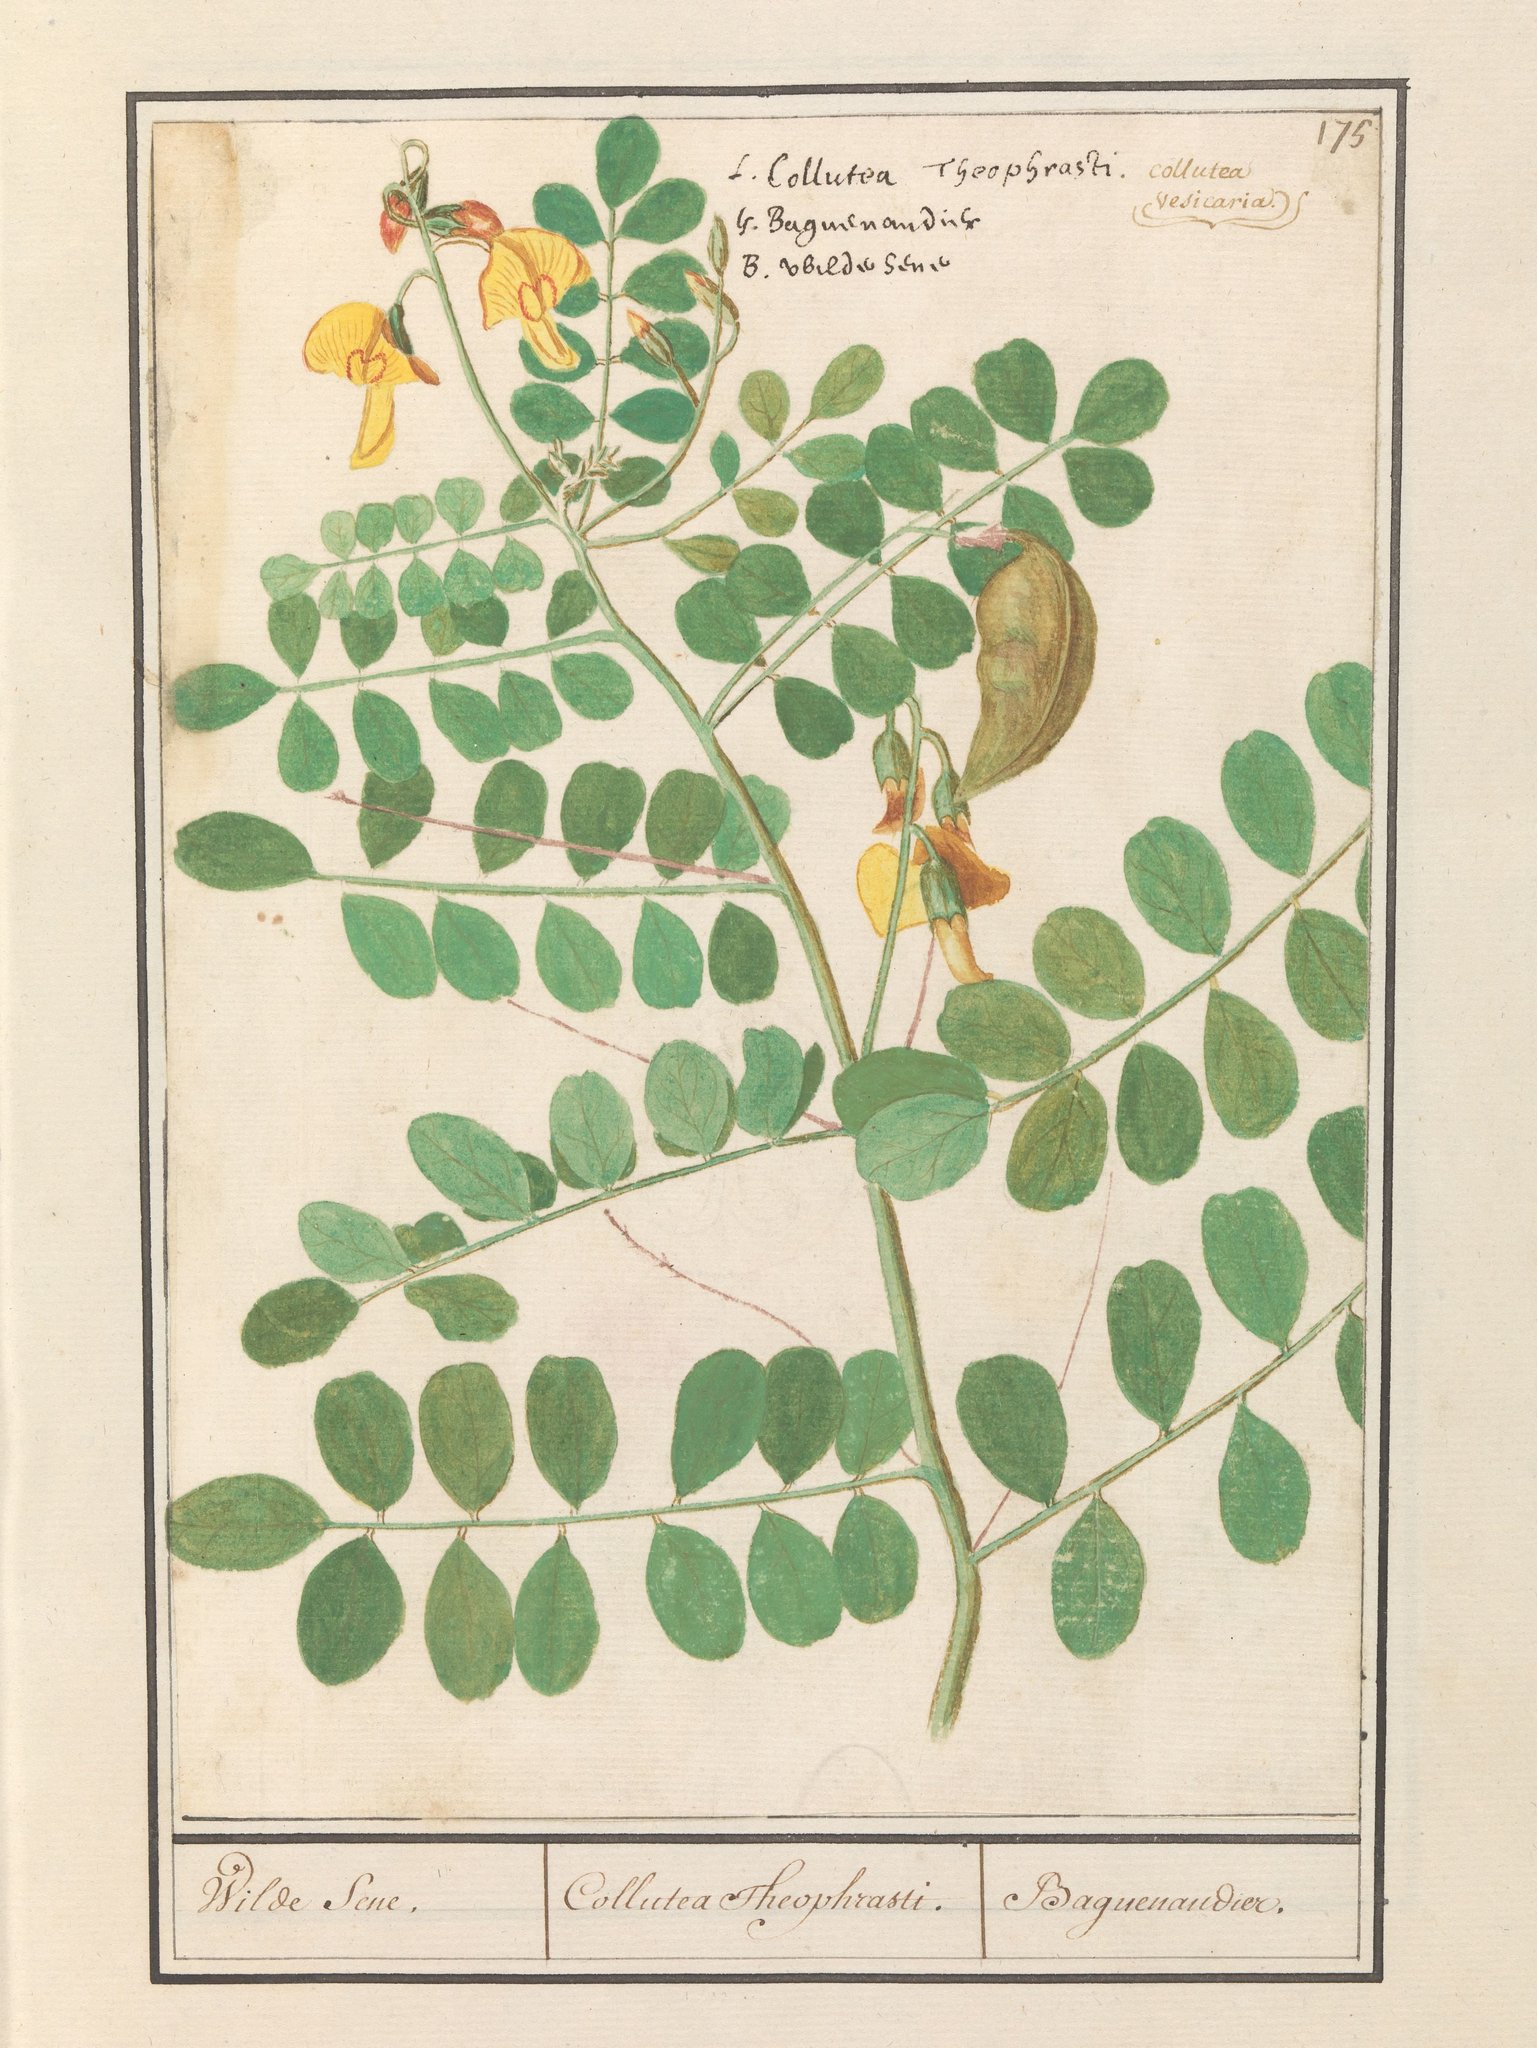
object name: drawing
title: Linze (Lens culinaris)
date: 1596-1610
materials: chalk, paint, ink, paper, watercolor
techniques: brush, pen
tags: plants and herbs: lentil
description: Wilde linze met gele bloemen. Rechtsboven genummerd: 175. Bovenaan de naam in drie talen. Onderdeel van het tweede album met tekeningen van bloemen en planten. Negende van twaalf albums met tekeningen van dieren, vogels en planten bekend rond 1600, gemaakt in opdracht van keizer Rudolf II. Met toelichting in Nederlands, Latijn en Frans.